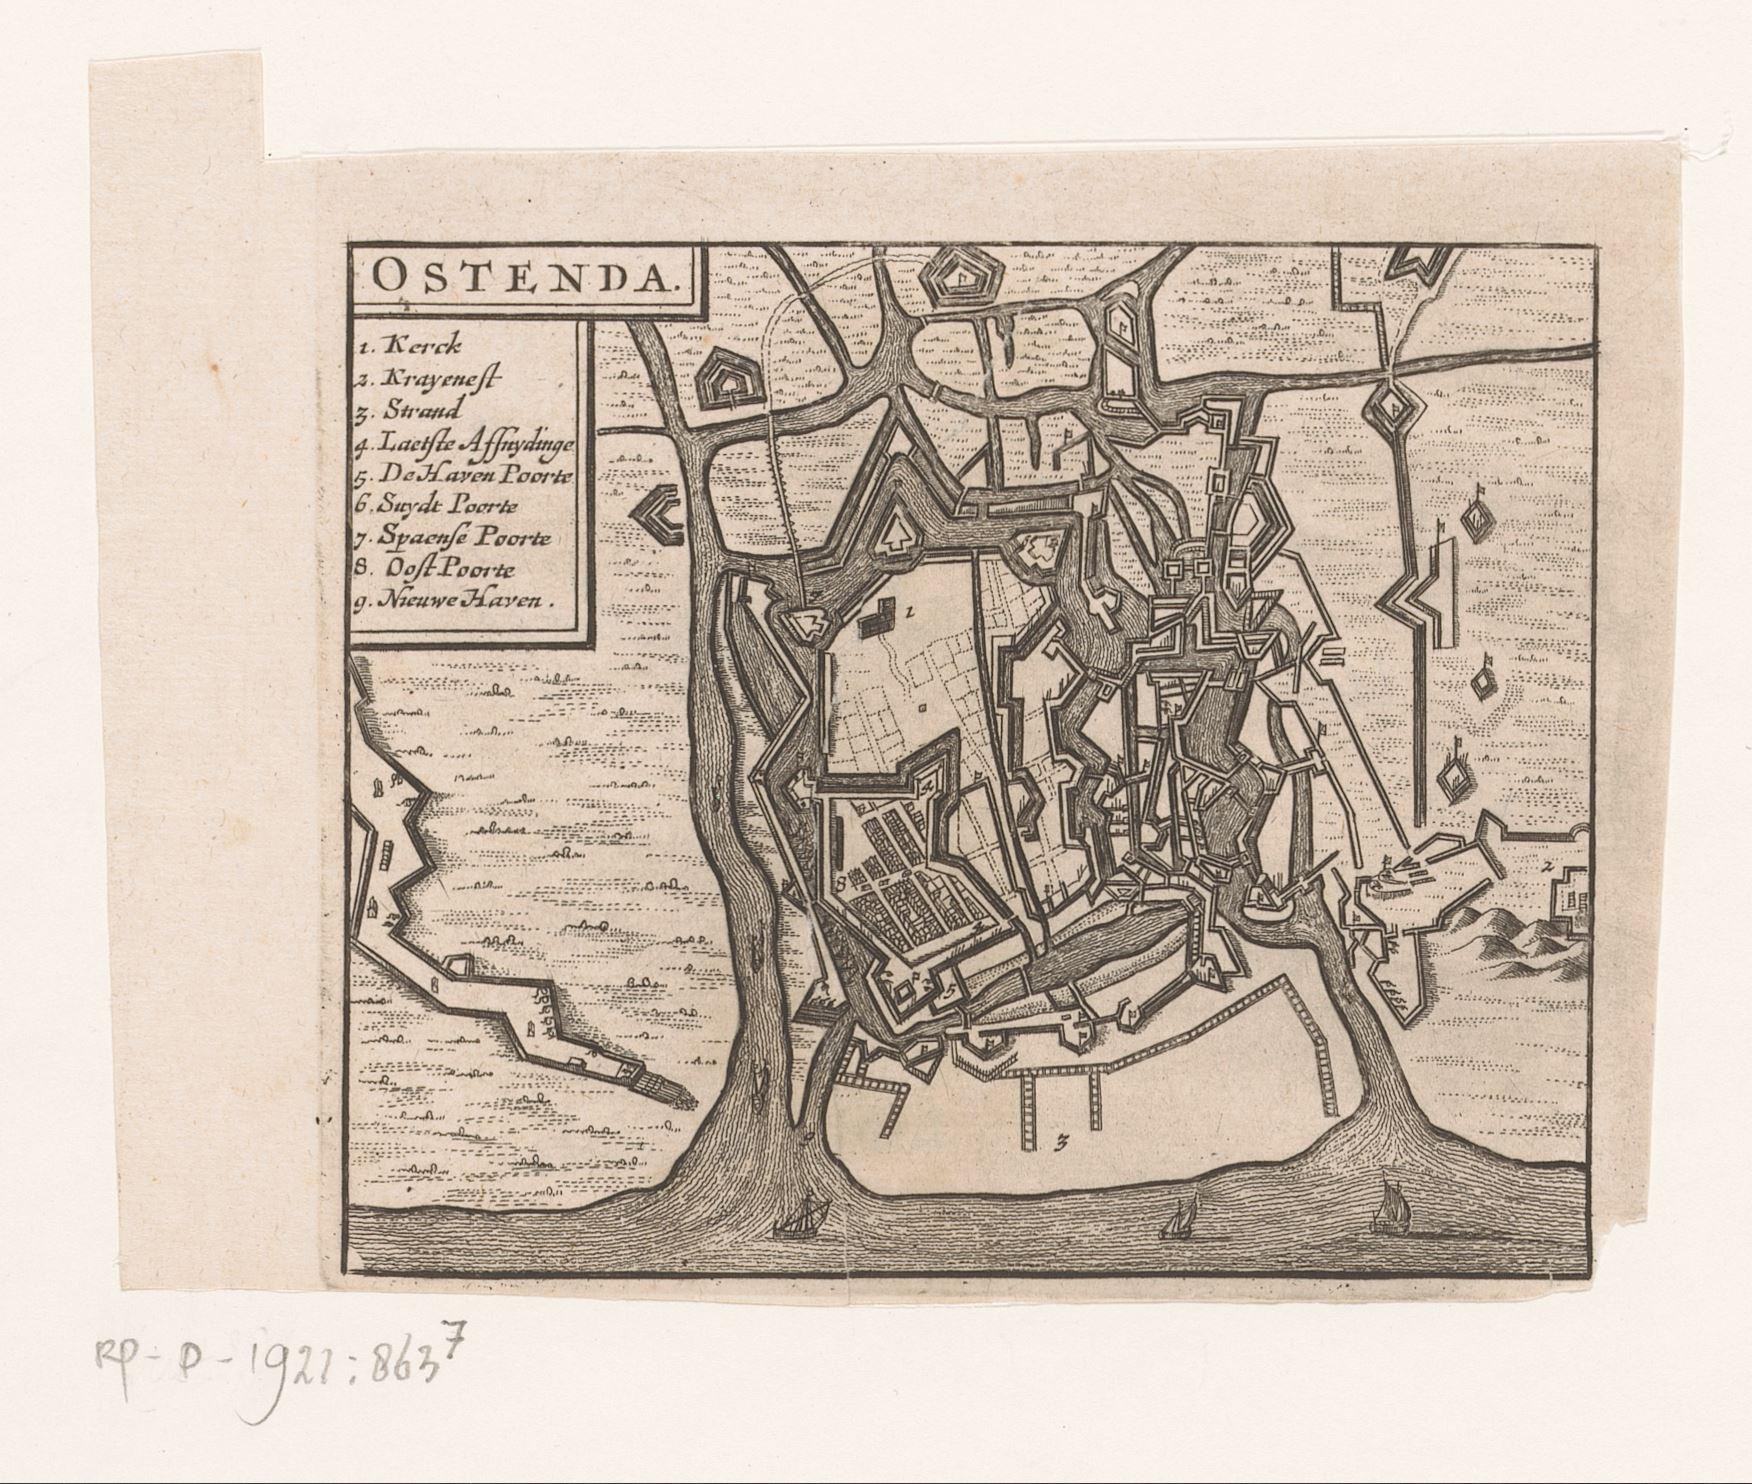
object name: book illustration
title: Ostenda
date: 1652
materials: paper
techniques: engraving, etching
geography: amsterdam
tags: maps of cities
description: Plattegrond uit: Guicciardini, Lodovico. Belgicae sive Inferioris Germaniae, descriptio (...). Amsterdam: Johannes Janssonius junior, 1652. Ook in: Guicciardini, Lodovico. Belgicae sive Inferioris Germaniae (...). Amsterdam: Jacob van Meurs, 1660. Tevens gebruikt in: Beschryvingh der Neder-landen; soo uyt Louis Guicciardijn als andere vermaerde schrijvers (...). 2 dln. Amsterdam: Jacob van Meurs, 1660 (en herdruk 1662). Komt ook voor in: Caert en stedeboexken van Nederlandt. Amsterdam: Jan Janssen Brouwer, 1652.